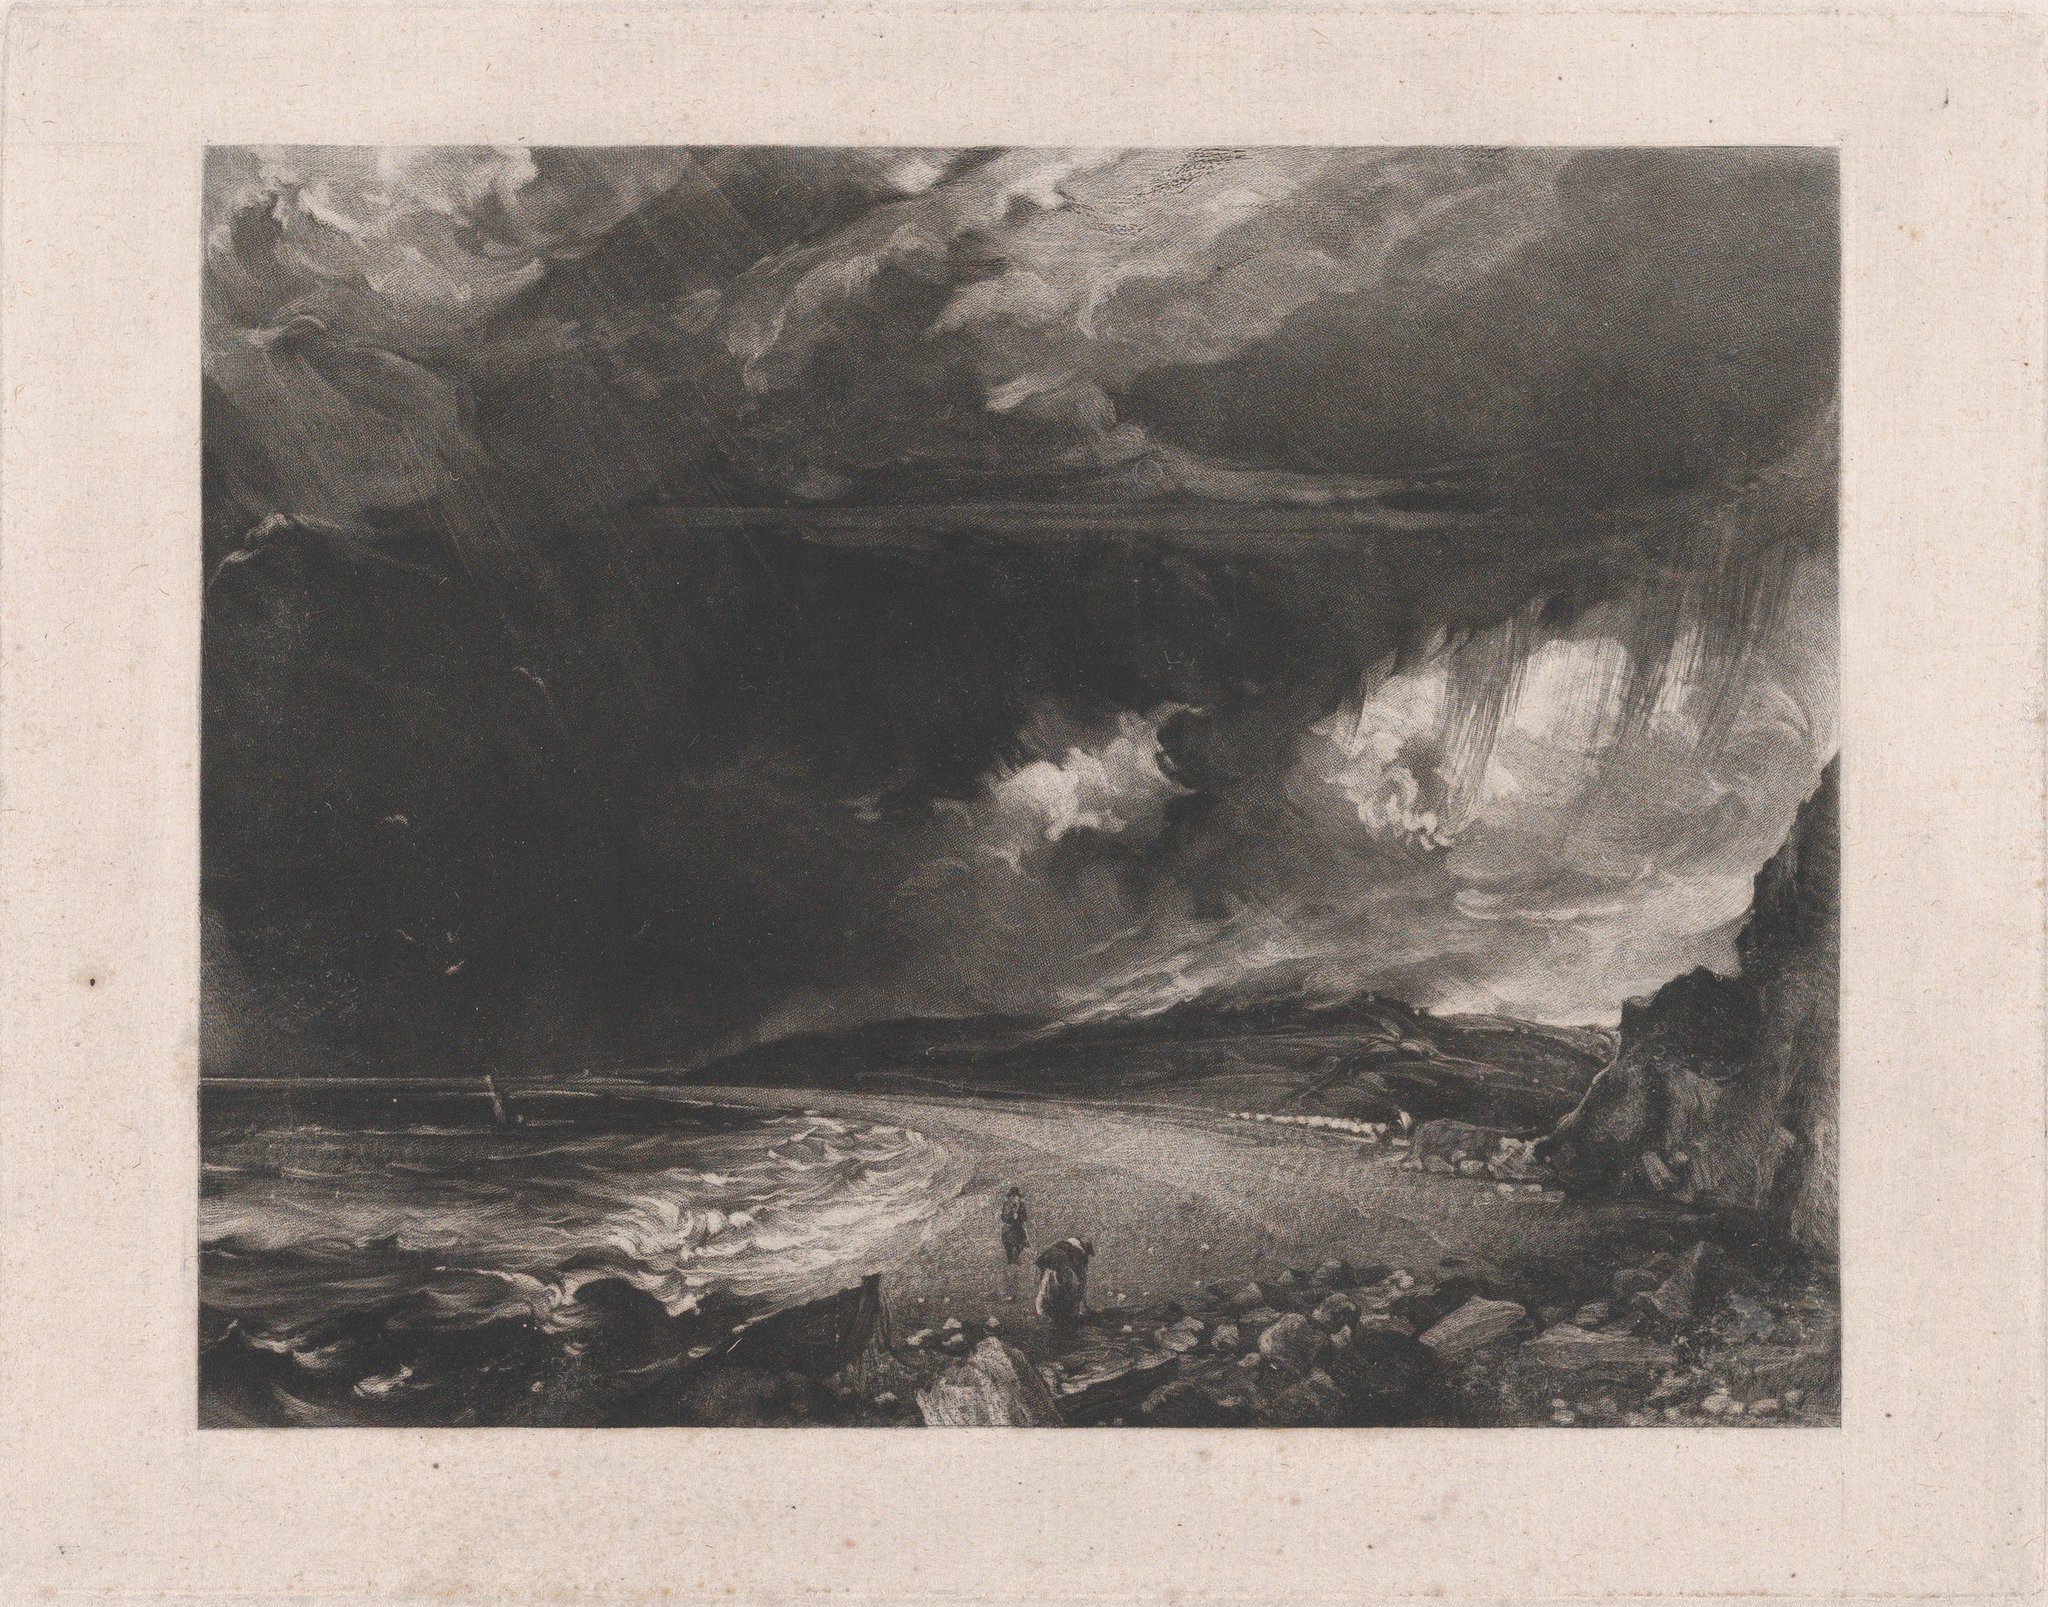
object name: print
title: Weymouth Bay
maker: david lucas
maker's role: artist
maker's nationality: british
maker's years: 1802-1881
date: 1830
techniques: mezzotint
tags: beaches,landscapes,waves,clouds